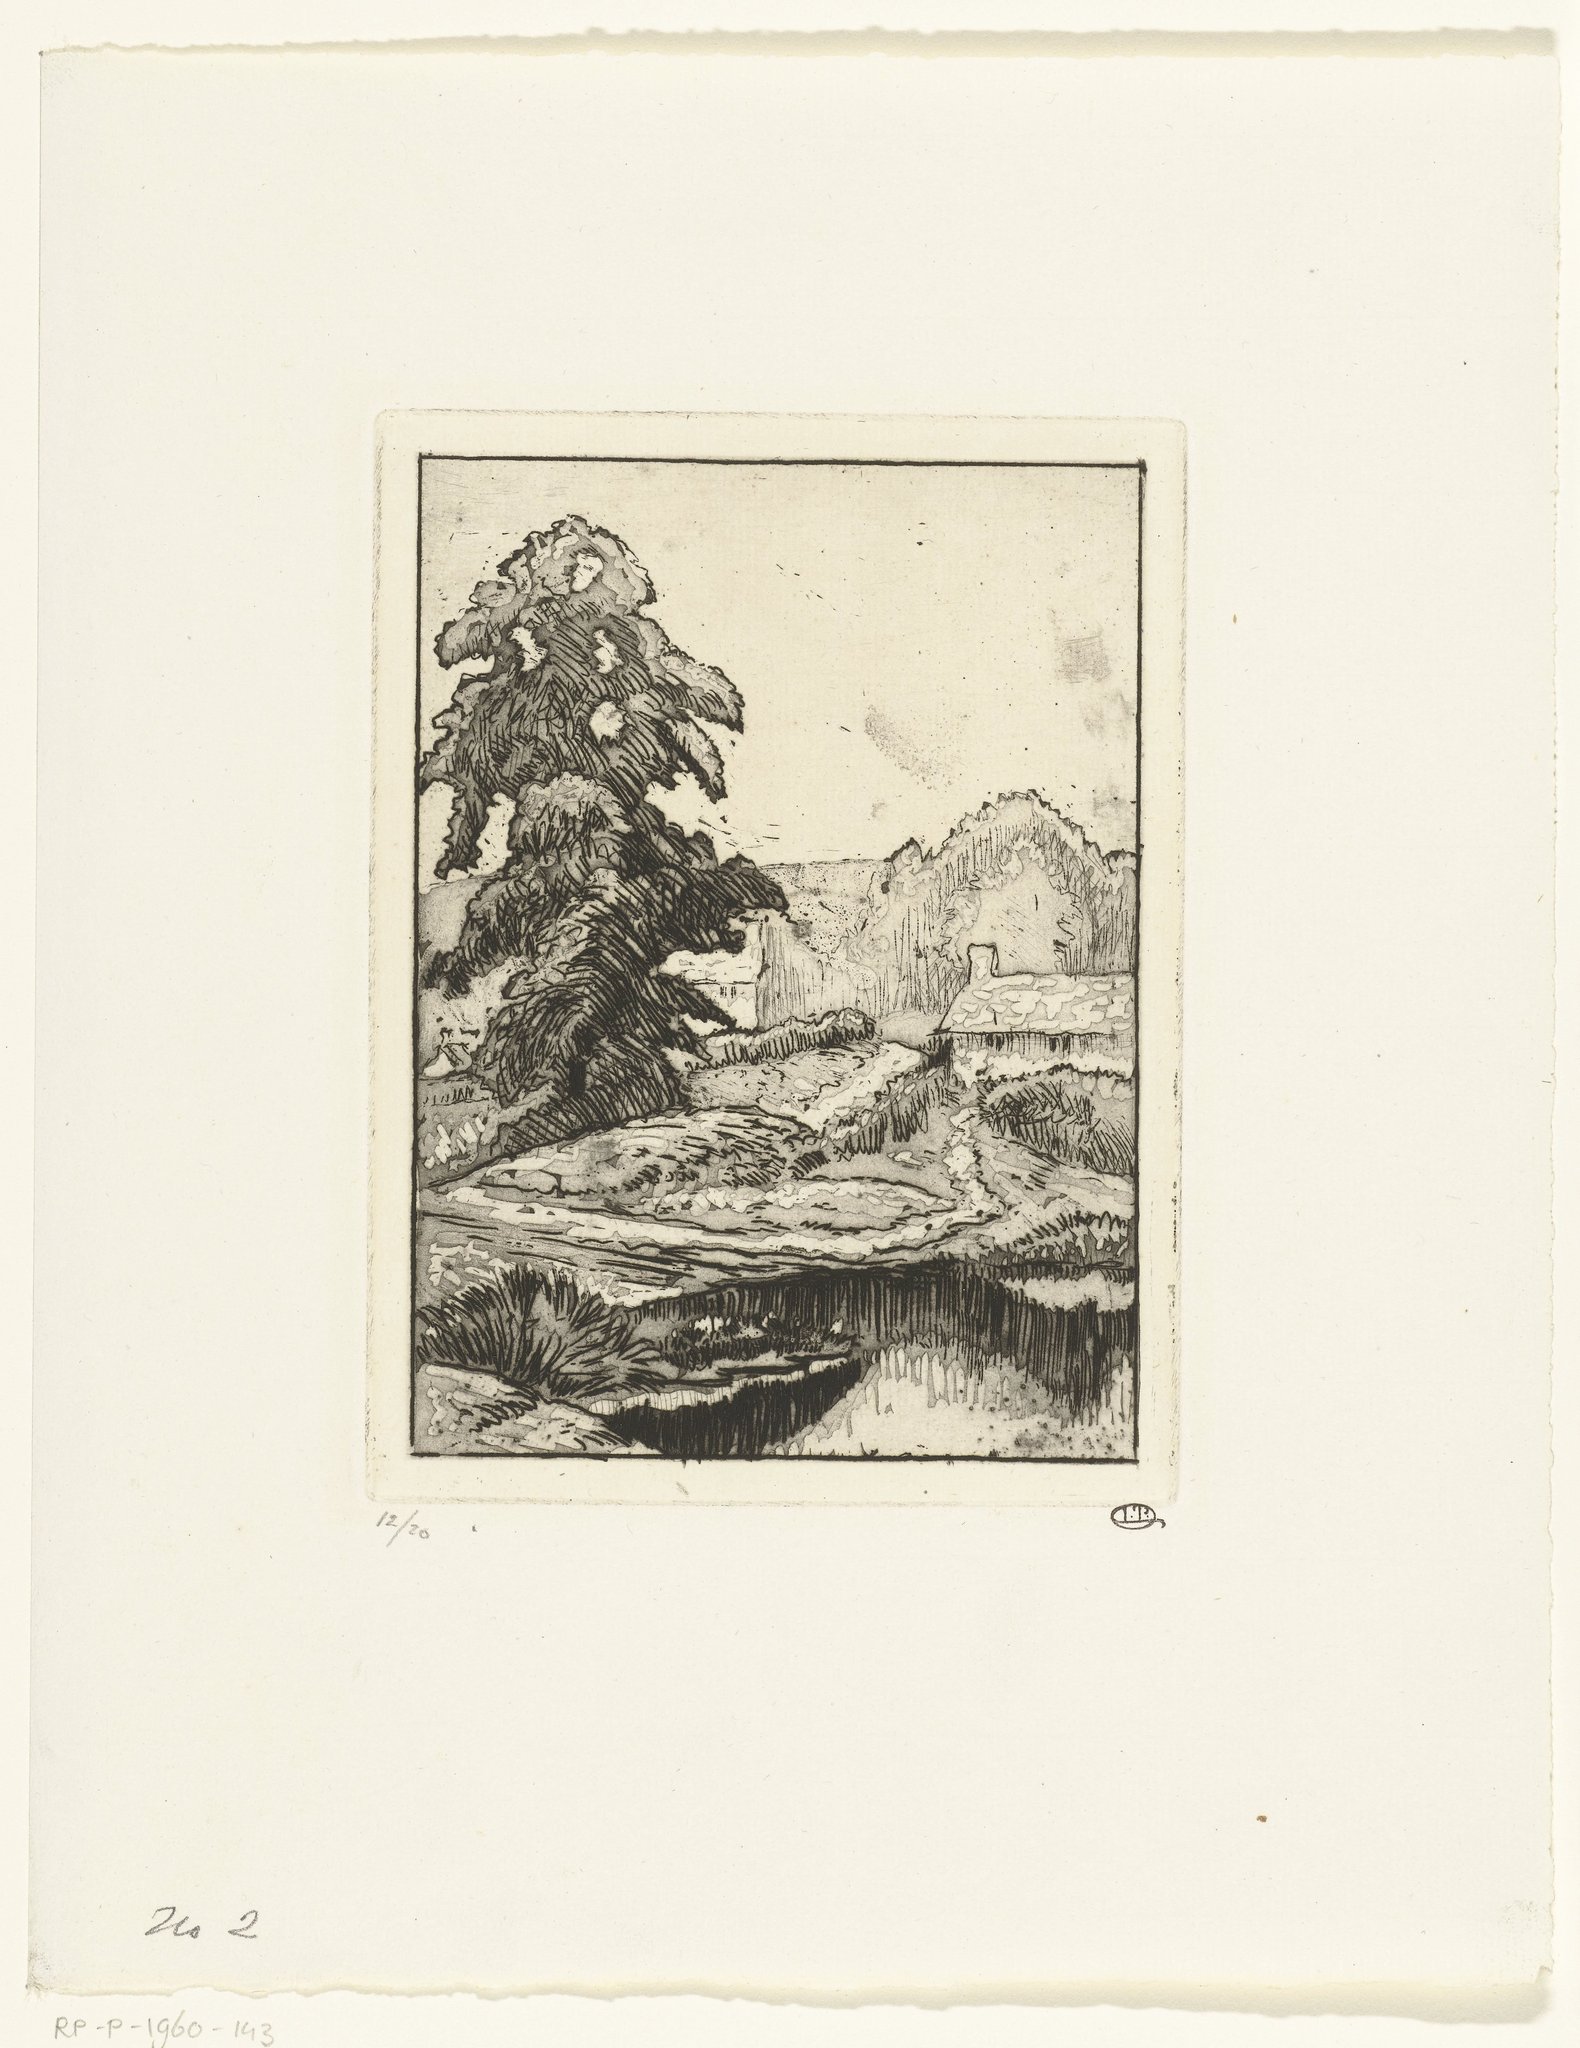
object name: print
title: Landschap met een grote boom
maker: lucien pissarro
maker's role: painter, print maker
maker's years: 1863-1944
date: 1873-1944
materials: paper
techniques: aquatint, etching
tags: landscapes in the temperate zone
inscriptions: collector's mark: Lugt 1756b, collector's mark: Lugt 2228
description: Landschap met pad naar een huis en een grote boom .